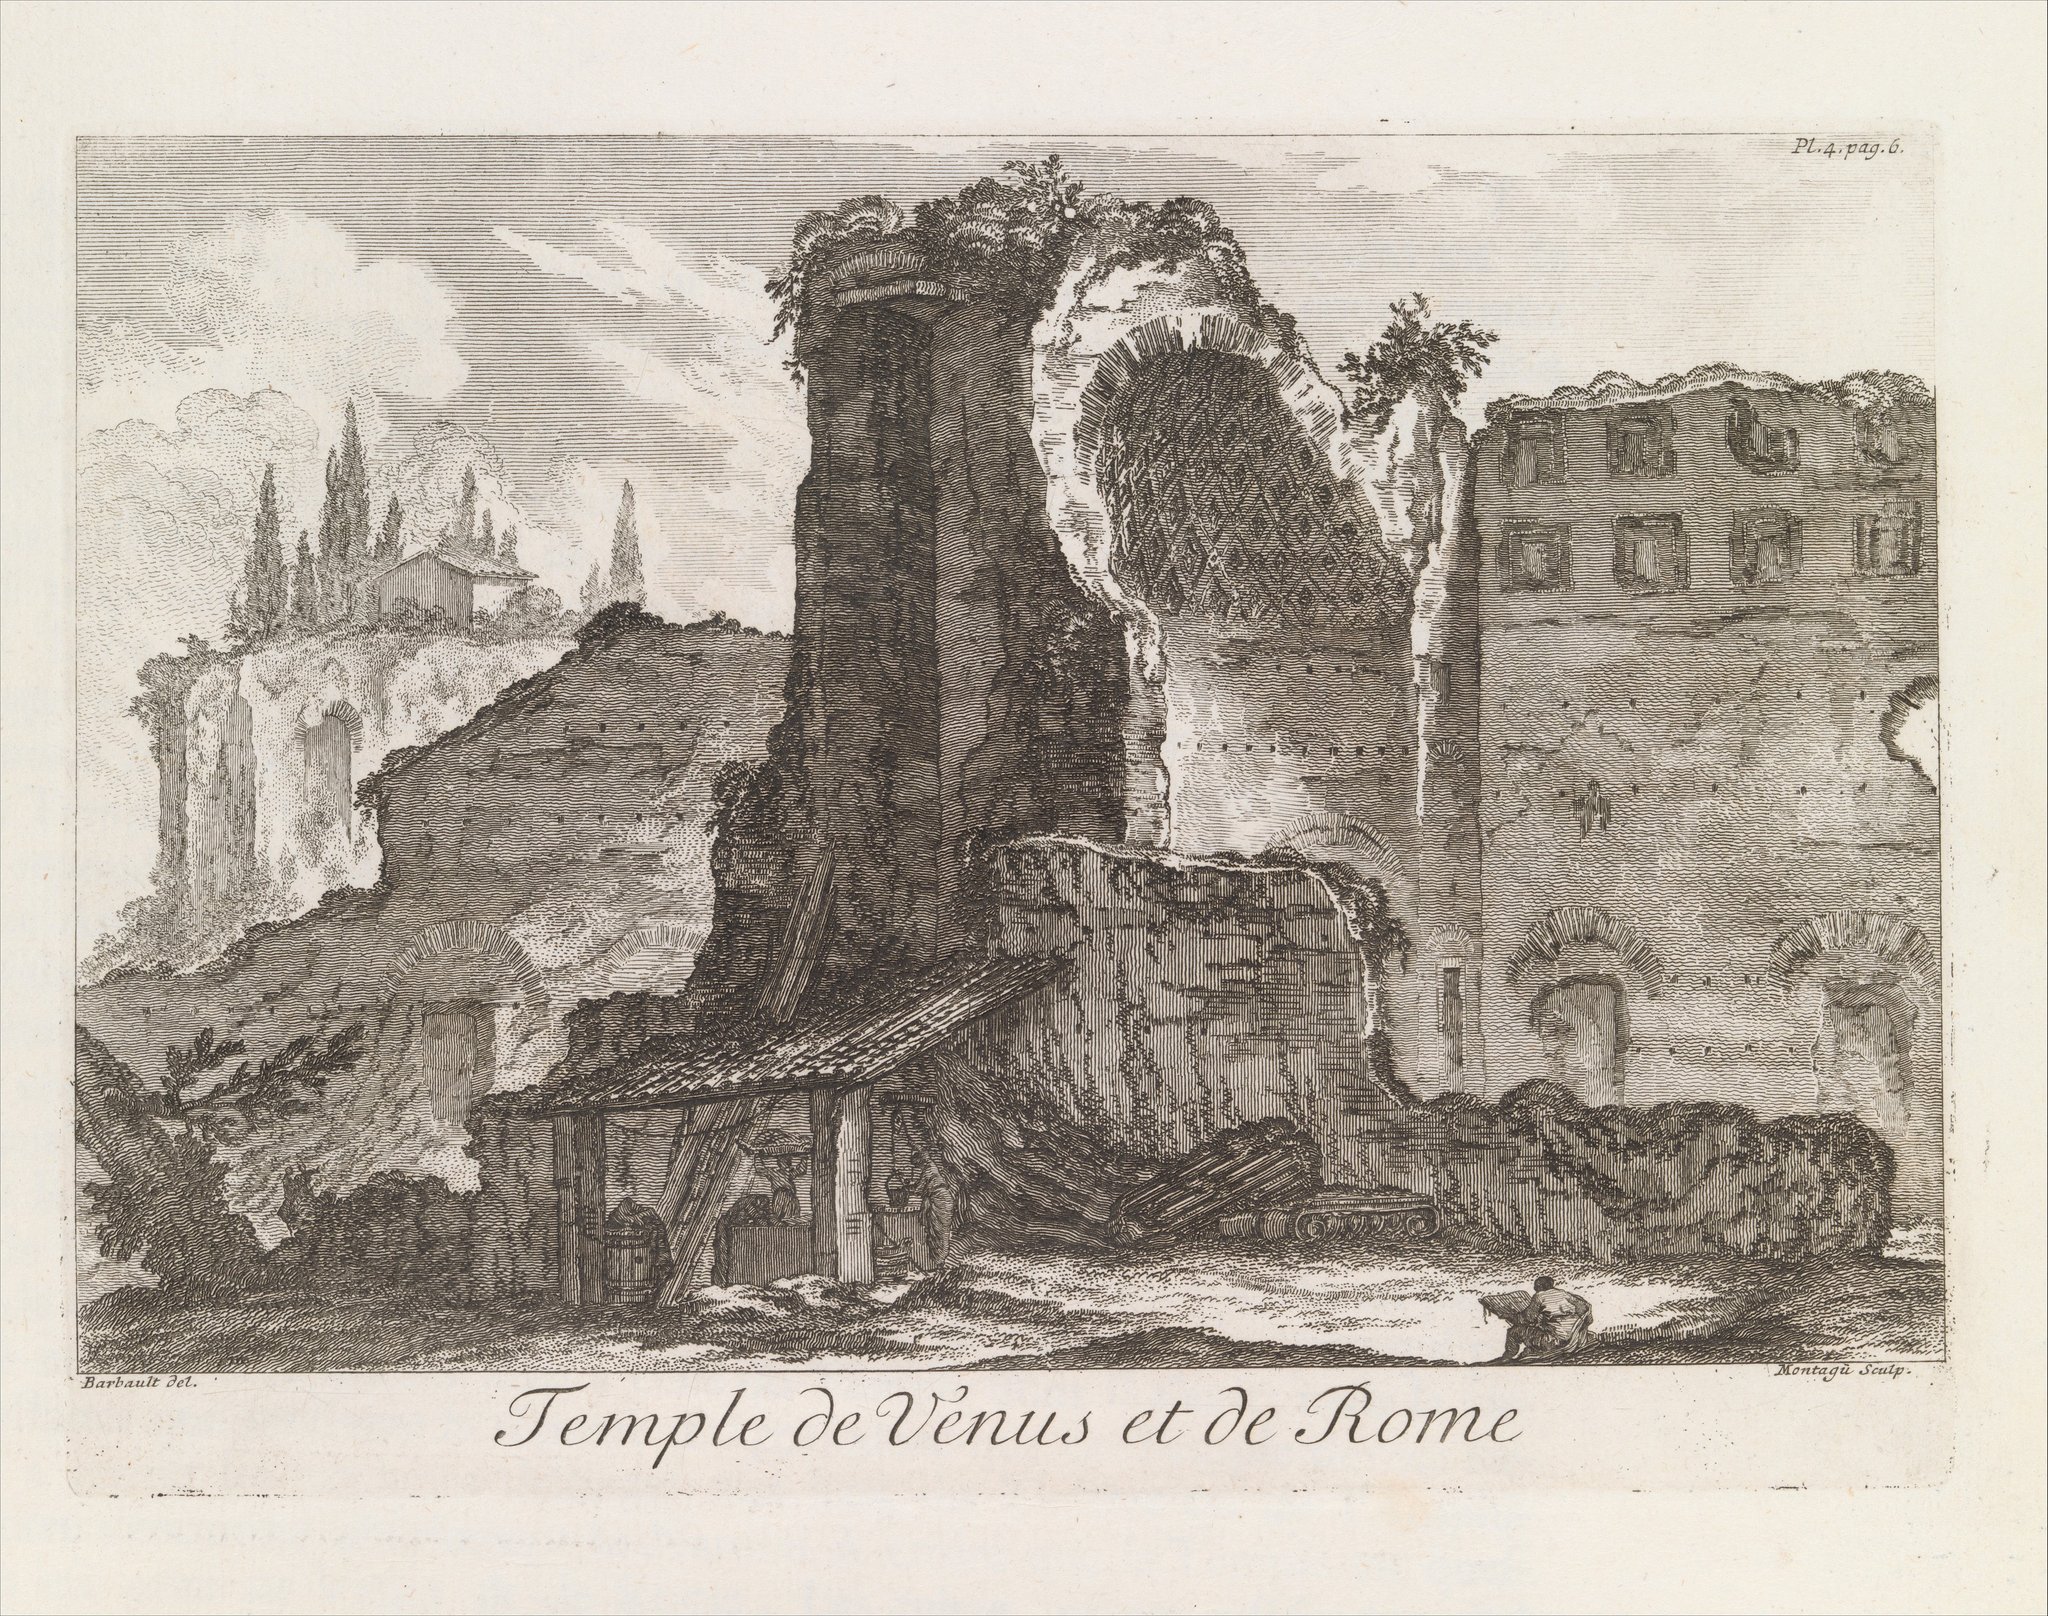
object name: print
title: Temple de Venus et de Rome, from Les Plus Beaux Monuments de Rome Ancienne ou Recueil des plus beaux Morceaux de l'Antiquité Romaine qui existent encore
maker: jean barbault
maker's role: artist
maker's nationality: french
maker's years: 1718-1762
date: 1761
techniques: etching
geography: italy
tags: monuments,temples,ruins,rome